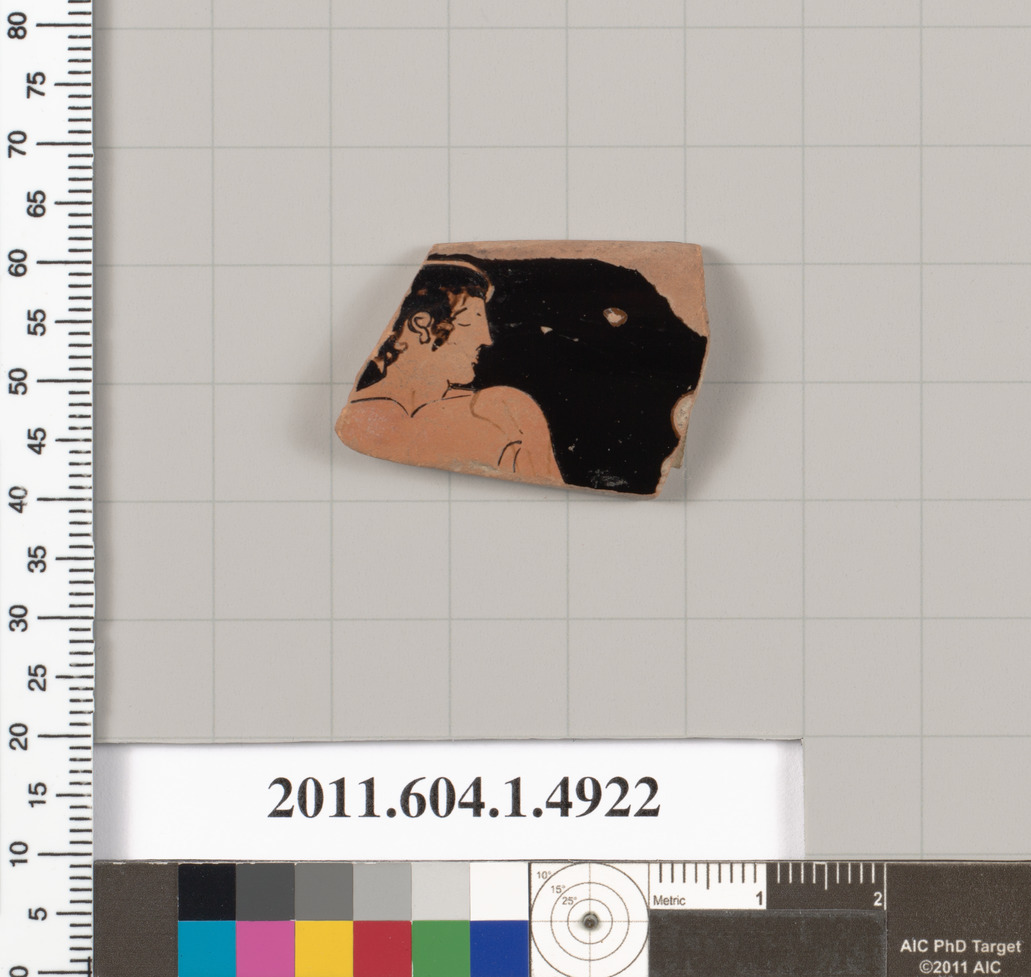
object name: kylix fragment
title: Terracotta rim fragment of a kylix (drinking cup)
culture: greek, attic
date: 460-450 BCE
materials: terracotta